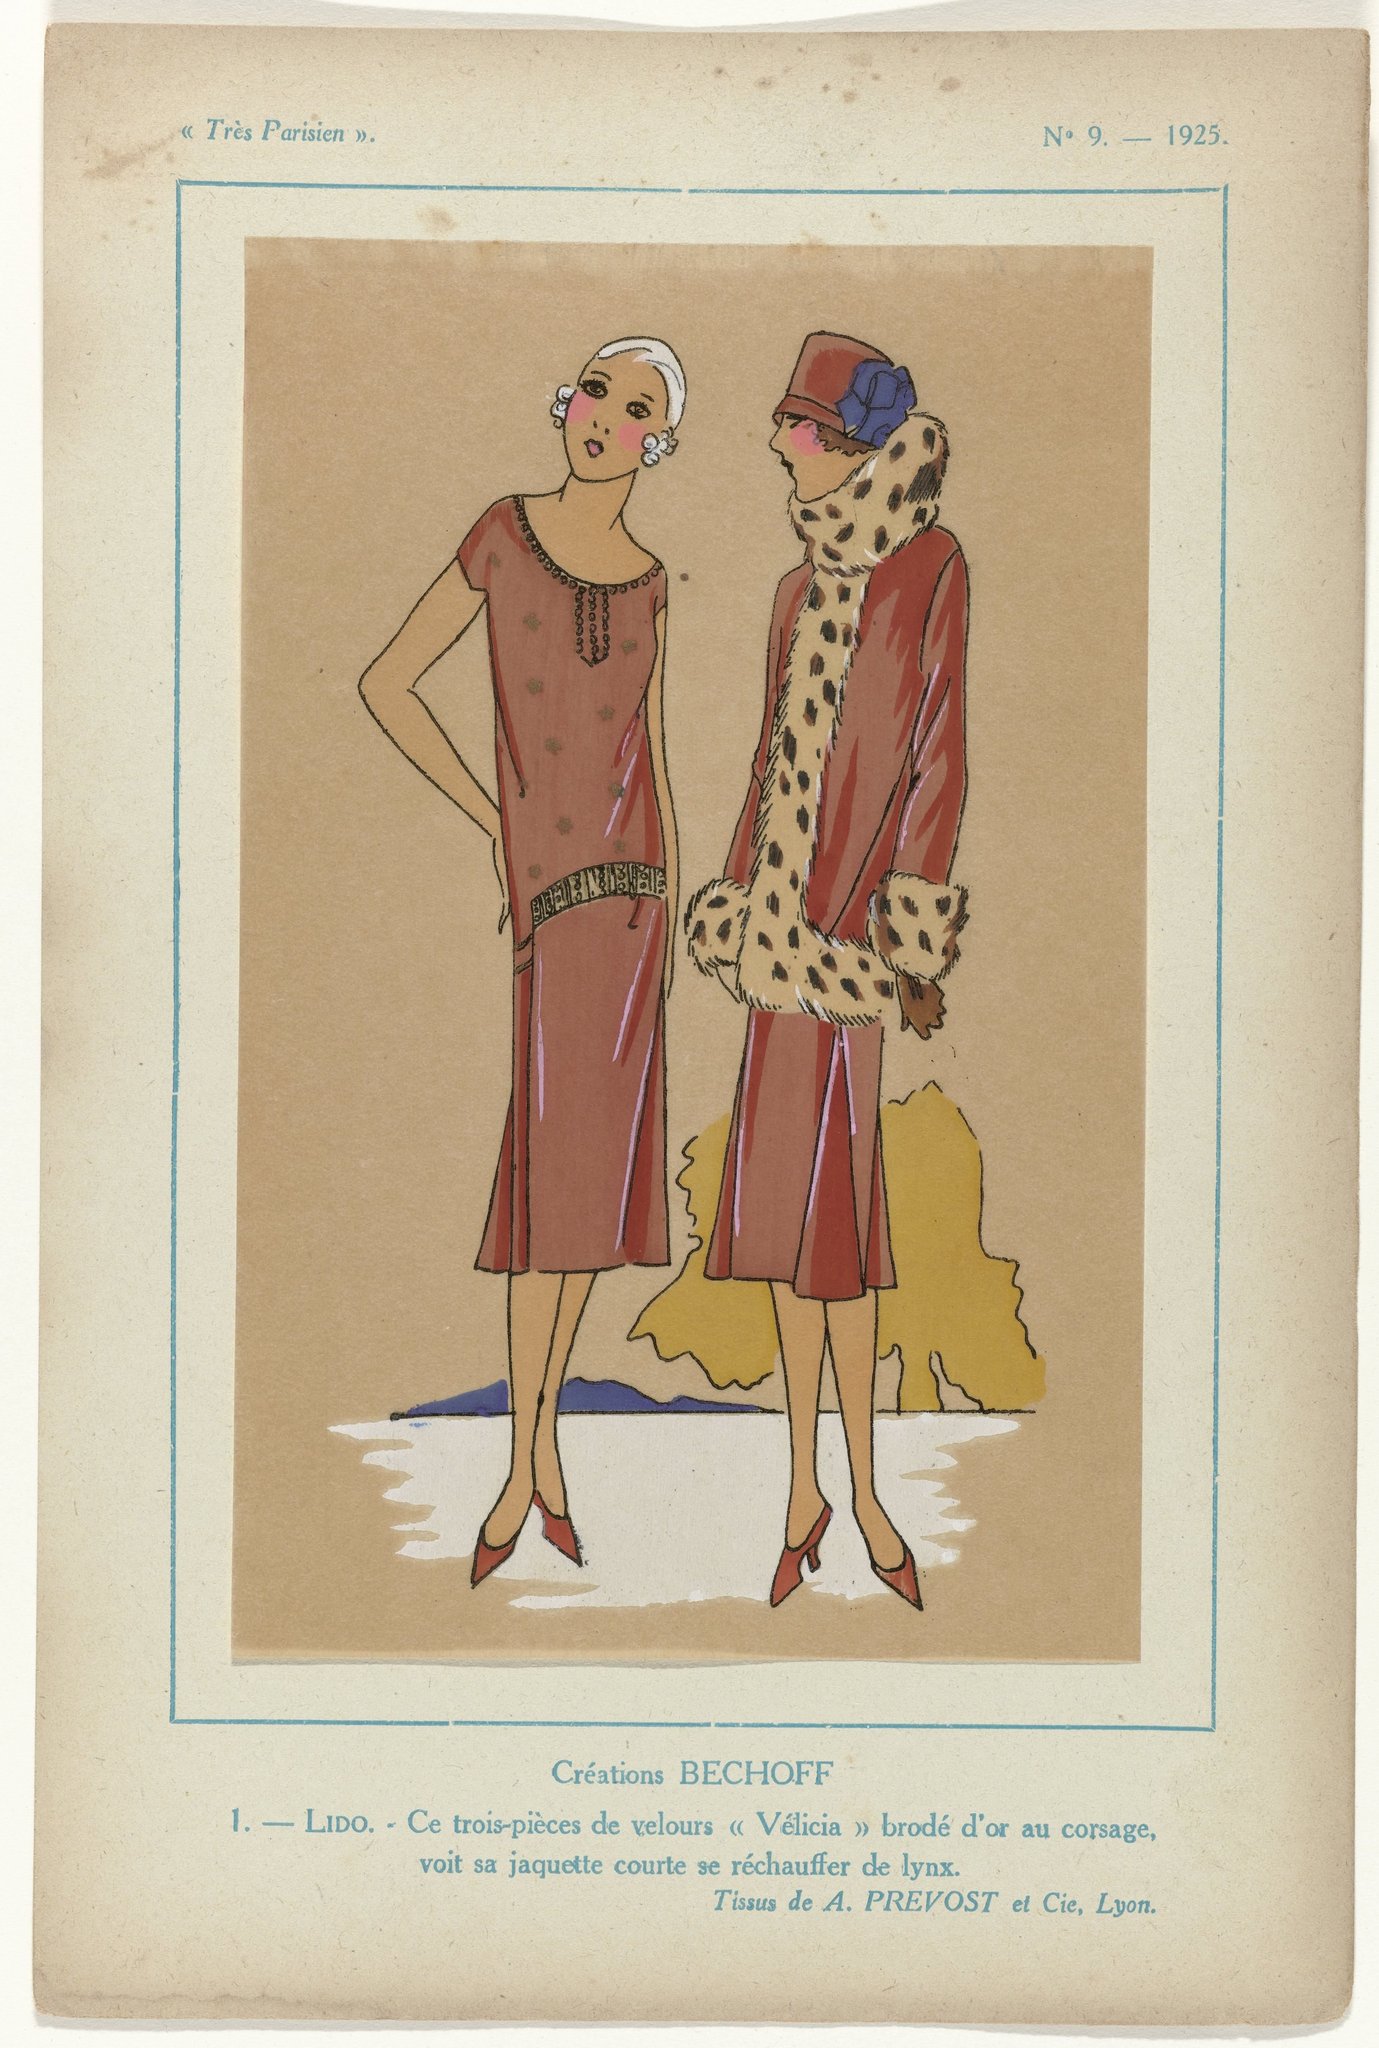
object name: fashion print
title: Très Parisien, 1925, No. 9, Pl. 1: Créations BECHOFF - LIDO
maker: g-p. joumard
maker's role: publisher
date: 1925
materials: paper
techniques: hand coloring, letterpress printing, lithography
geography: paris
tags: ensembles of pieces of clothing (three piece suit) (+ women's clothes), fashion plates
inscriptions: caption: ‘1: LIDO. - Ce trois-pièces de velours "Velicia" brodé d'or au corsage voit ca jaquette courte se réchauffer de lynx.’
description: Driedelig ensemble van bruin fluweel, waarvan het korte jasje is afgezet met bont van de lynx. Prent uit het modetijdschrift Très Parisien...La Mode, Le Chic, L'Élégance (1920-1936)